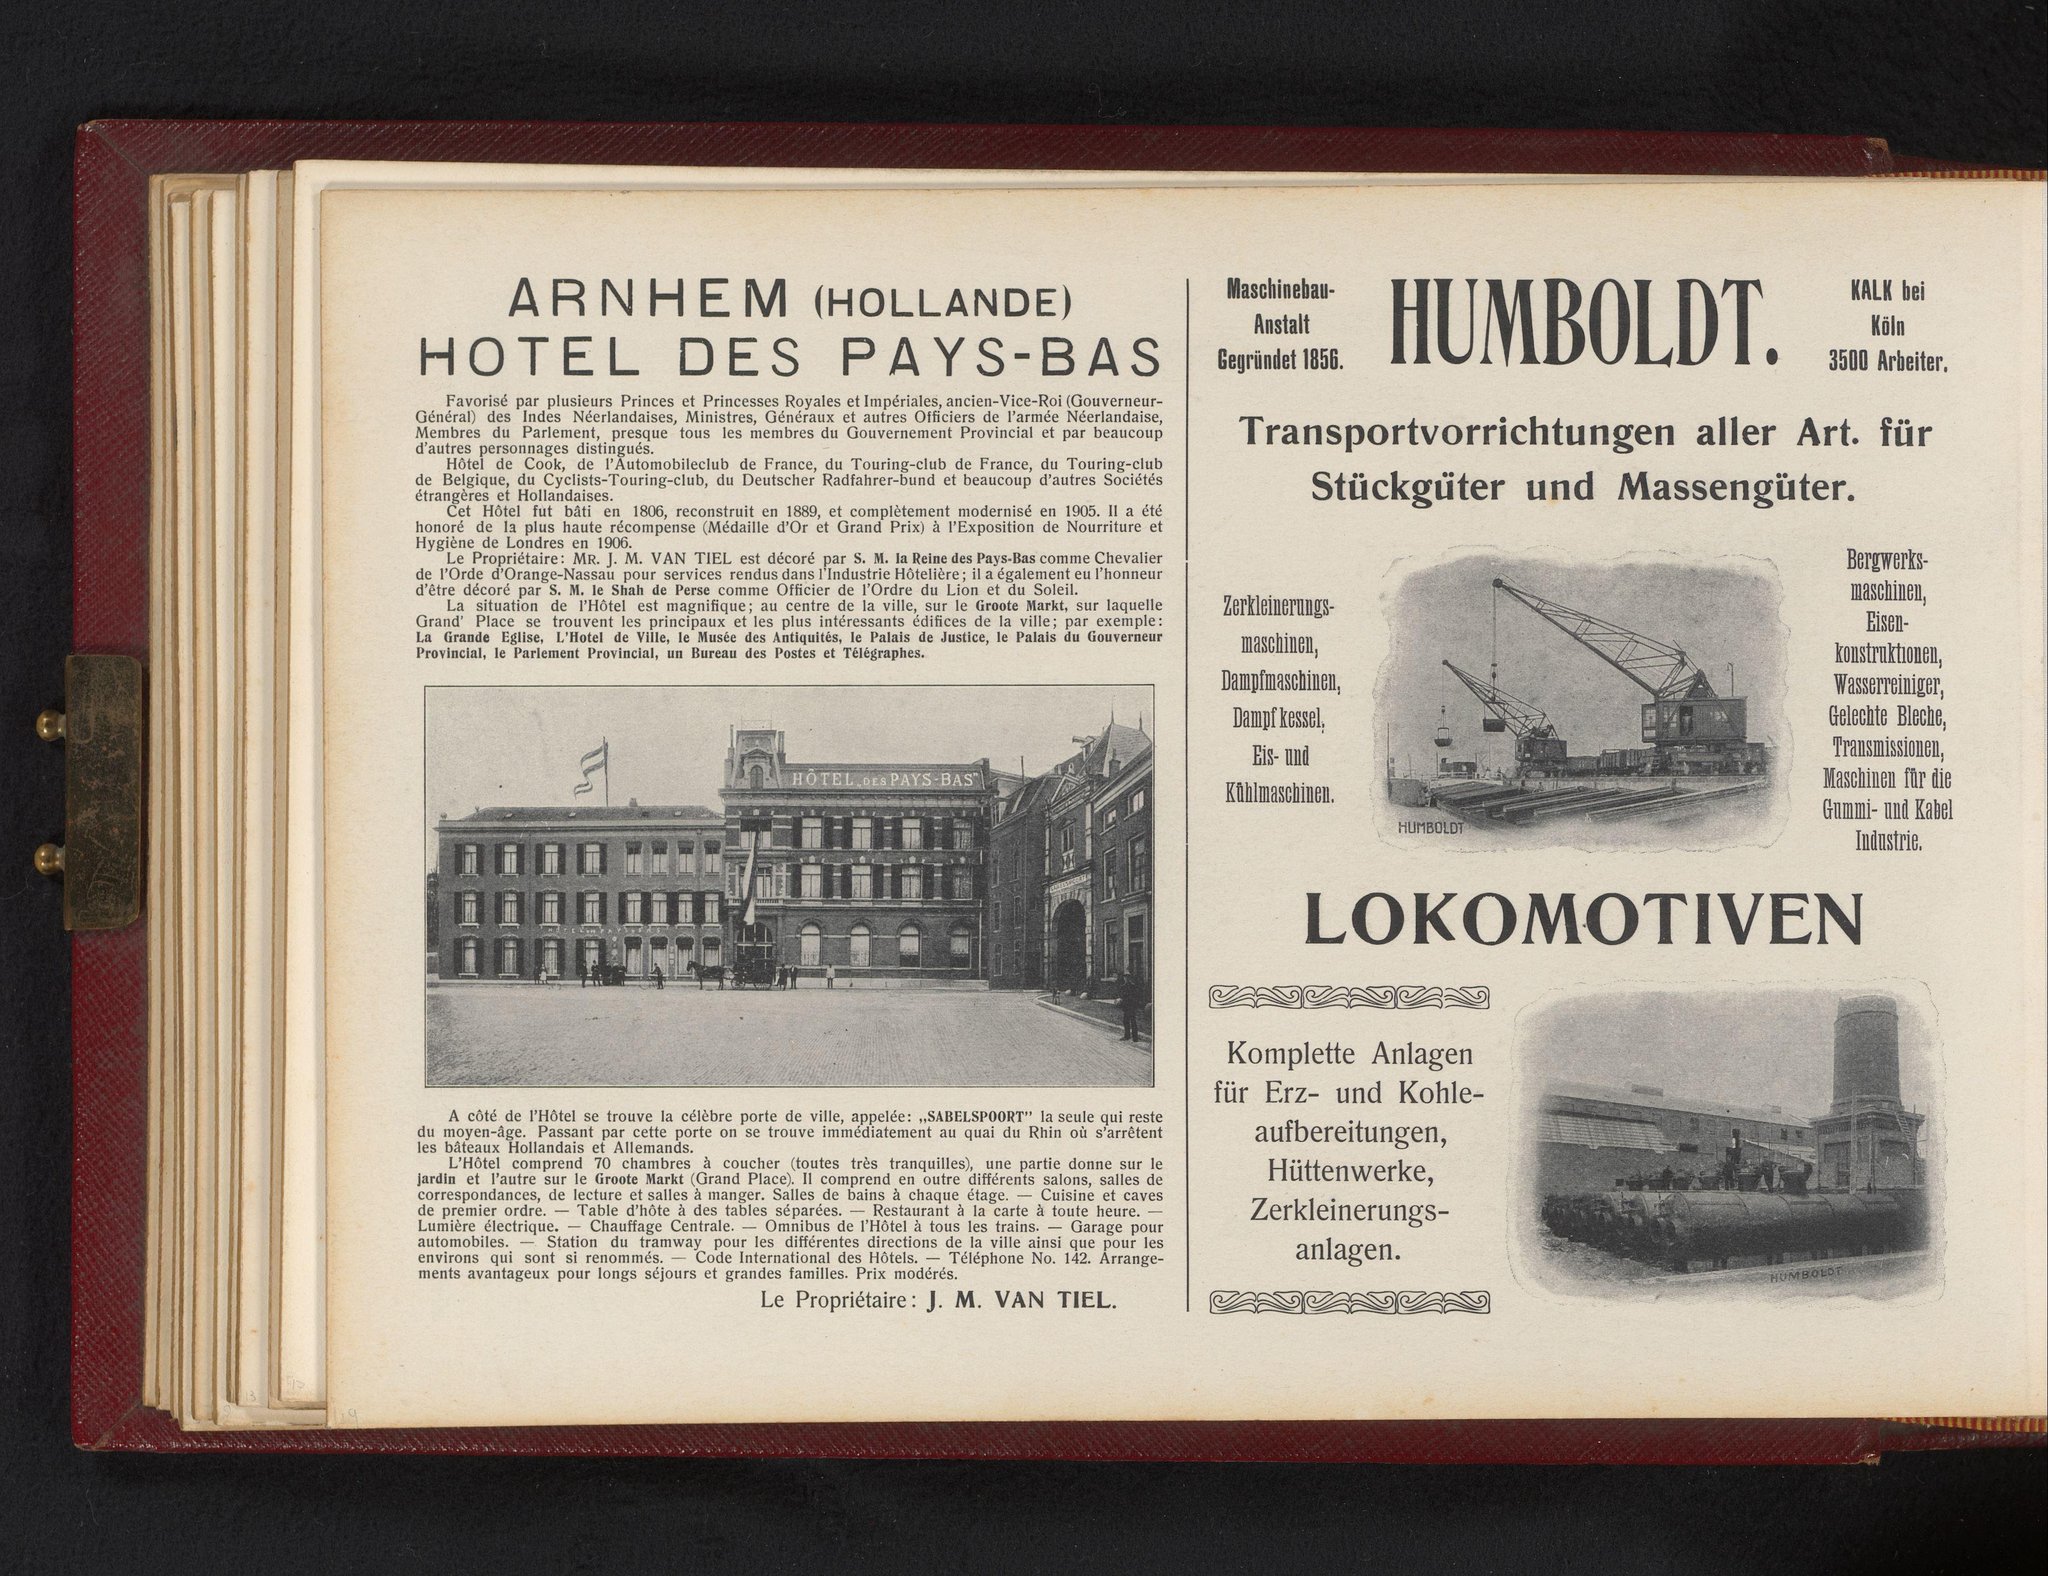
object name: album leaf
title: Advertenties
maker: Anonymous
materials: paper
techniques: printing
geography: netherlands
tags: advertising, locomotive, hotel, hostelry, inn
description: Advertenties voor onder andere Hotel des Pays-Bas te Arnhem en voor Humboldt Lokomotieven. Deze pagina maakt deel uit van een album.